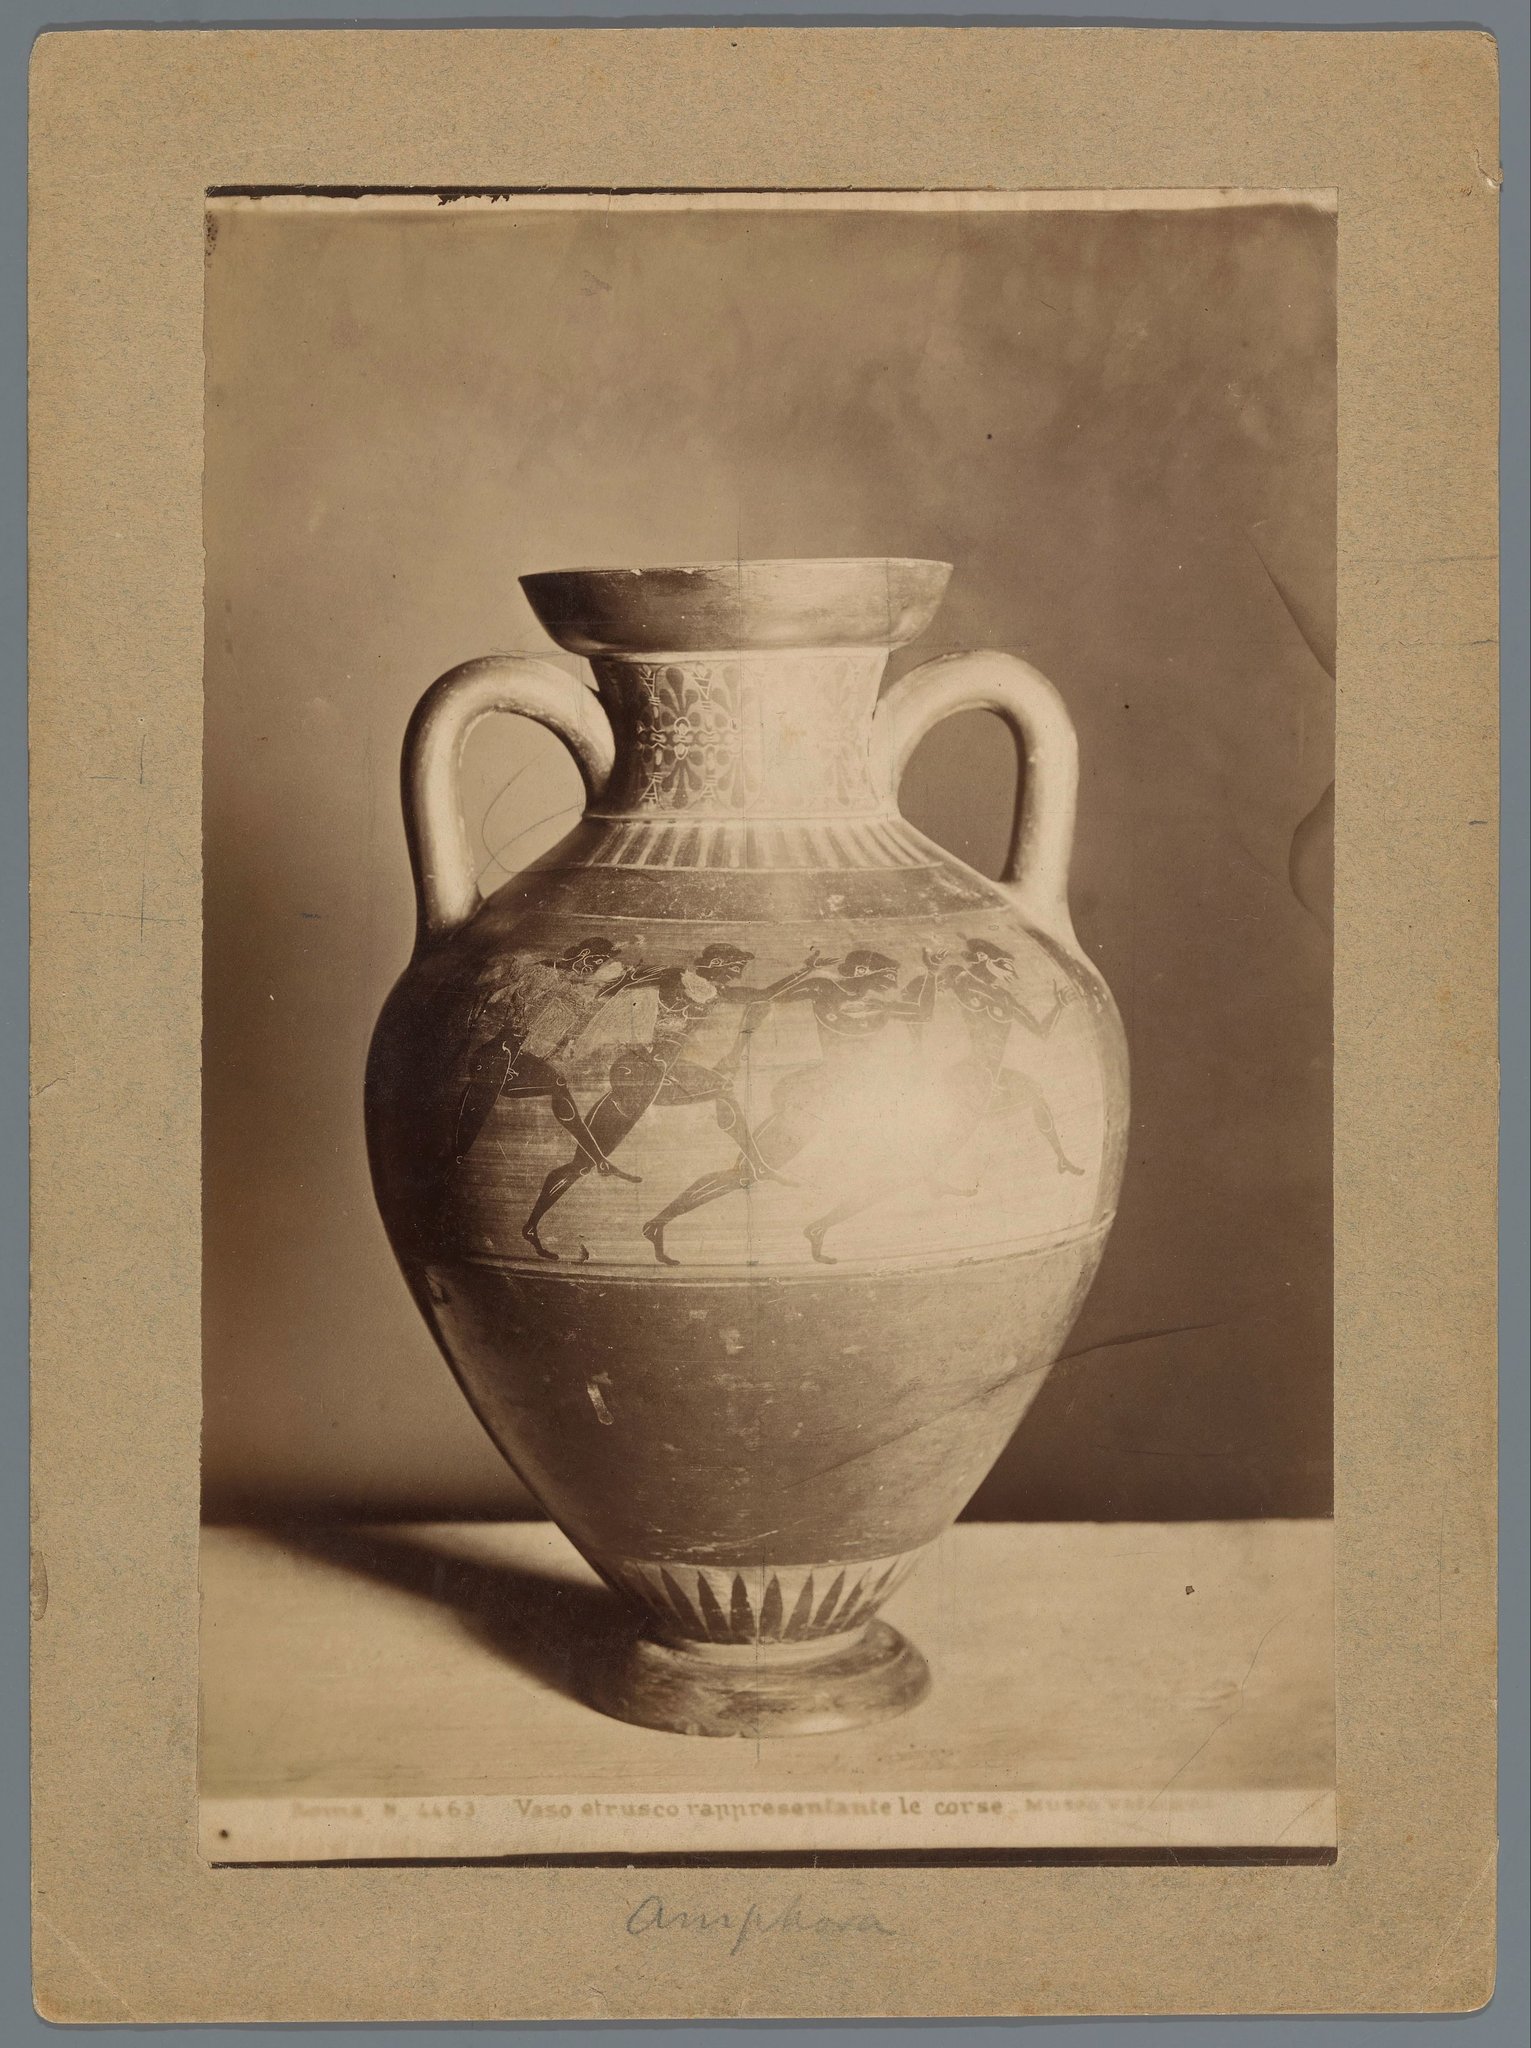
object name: photograph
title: Vaso etrusco rappresentante le corse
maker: Anonymous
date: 1875-1900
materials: cardboard, photographic support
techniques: albumen print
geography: europe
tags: container of stone: stone vase, italy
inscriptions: collector's mark: Lugt 3937, inscription: ‘Museo [...]’, number: ‘N 4463’